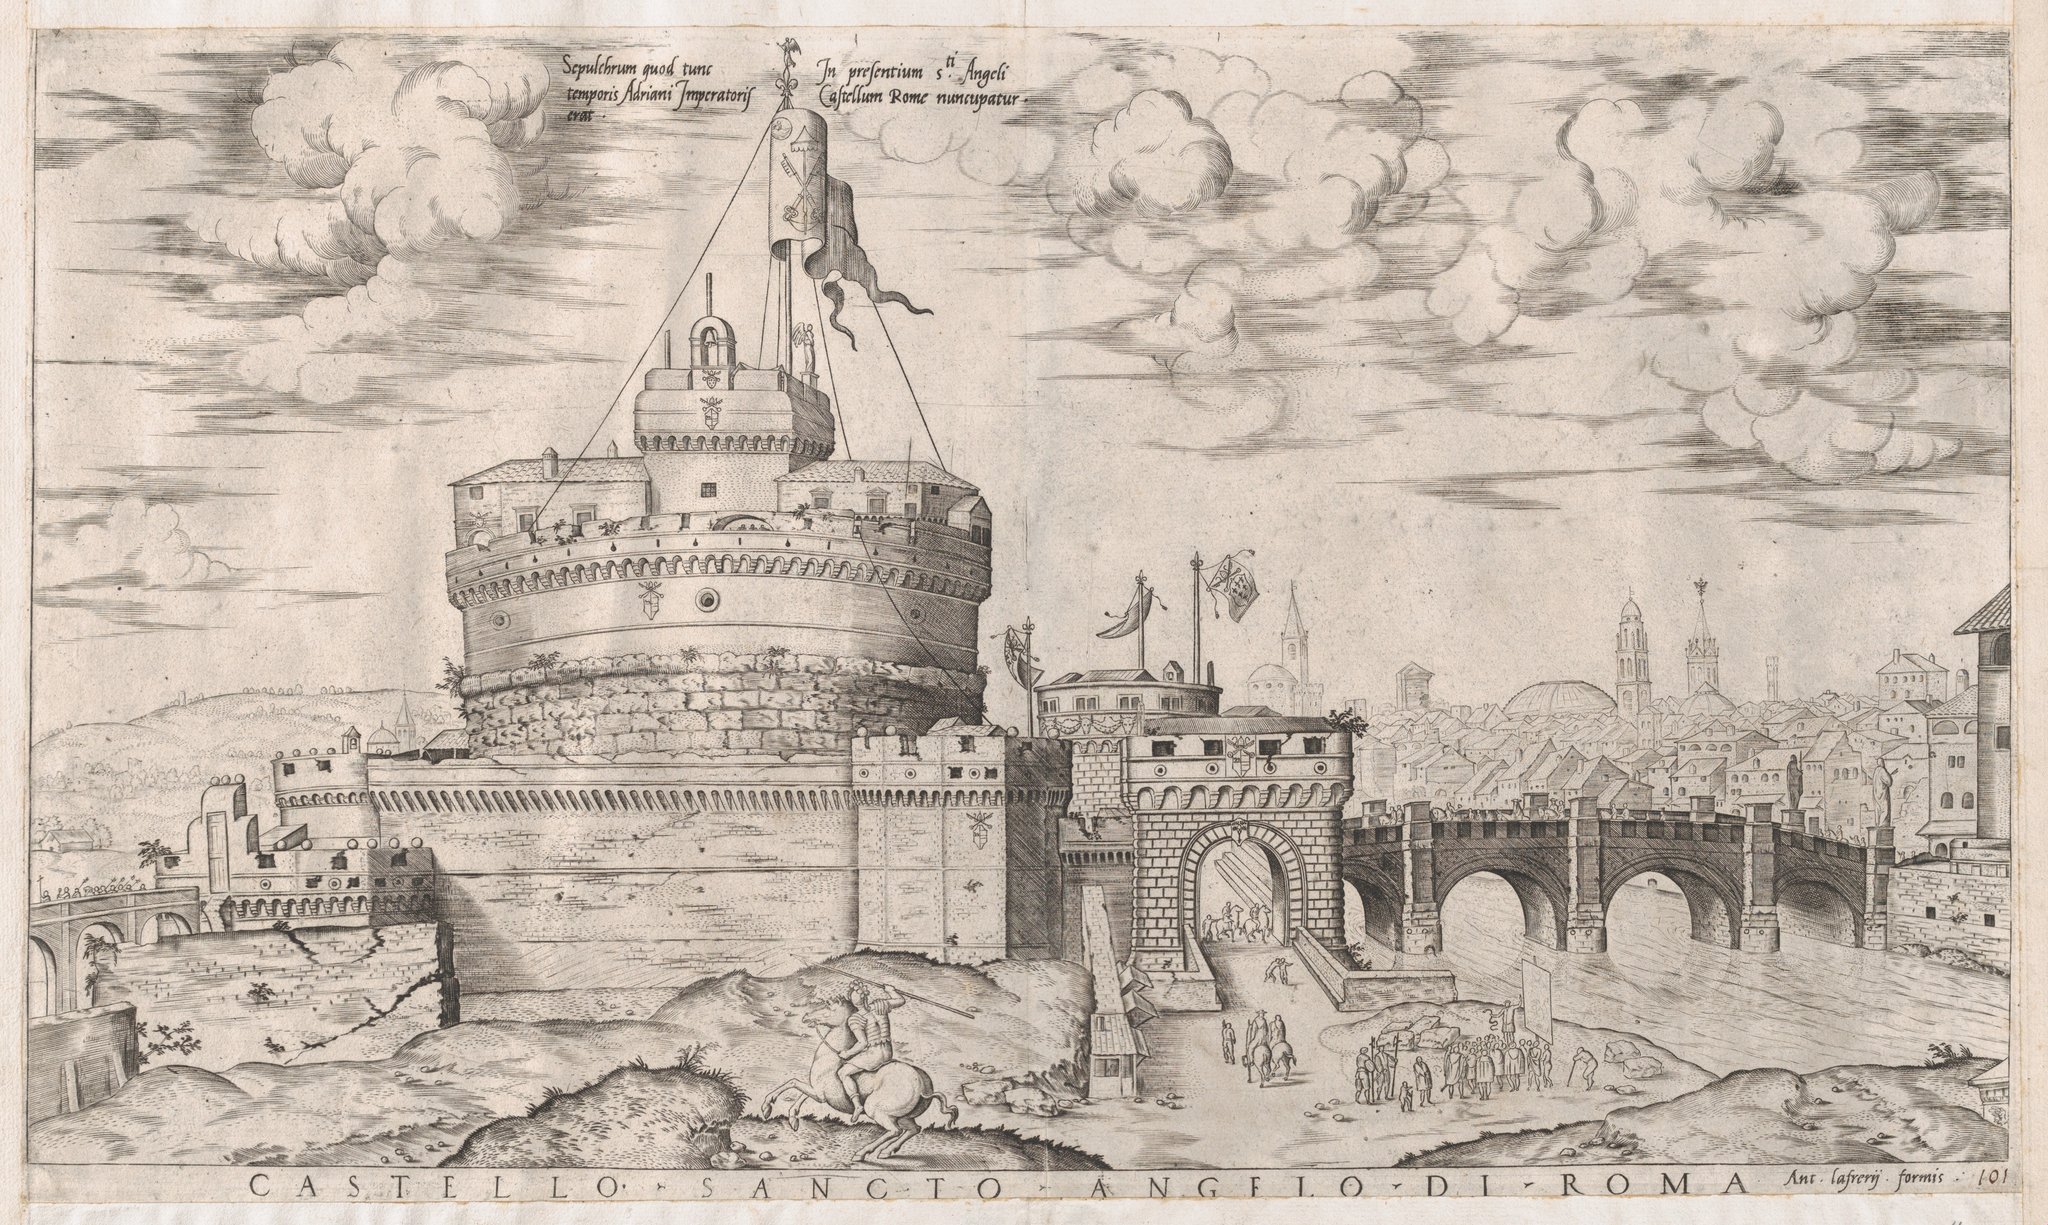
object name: print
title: Castello Sant' Angelo, from "Speculum Romanae Magnificentiae"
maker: Anonymous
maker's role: artist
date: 1501-1600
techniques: engraving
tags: buildings,rome